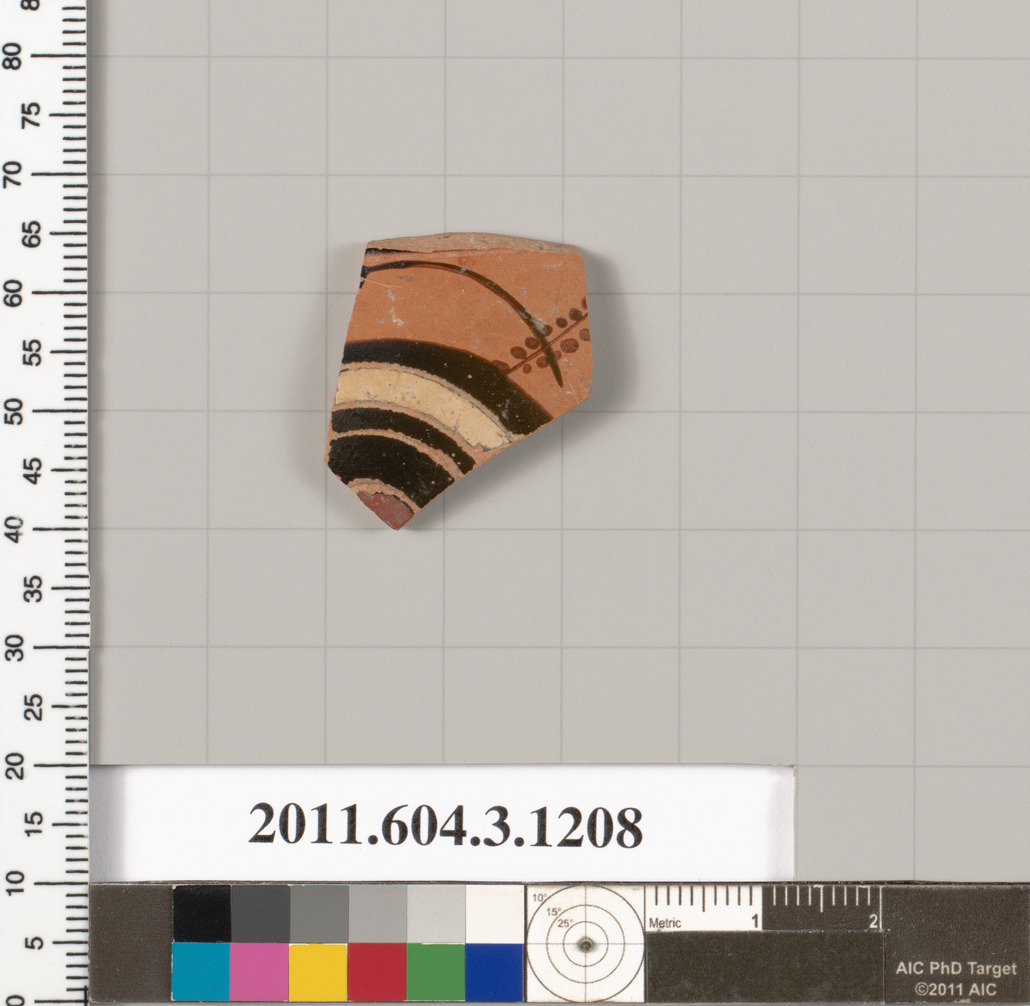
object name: mastoid fragment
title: Terracotta fragment of a mastoid (drinking cup with narrow base)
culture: greek, attic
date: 534-468 BCE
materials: terracotta